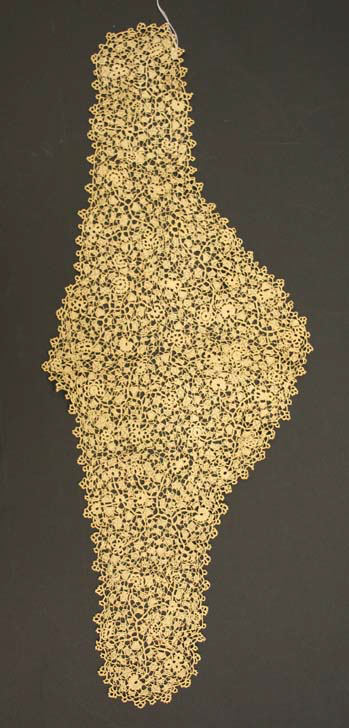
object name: cap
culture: irish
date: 1801-1900